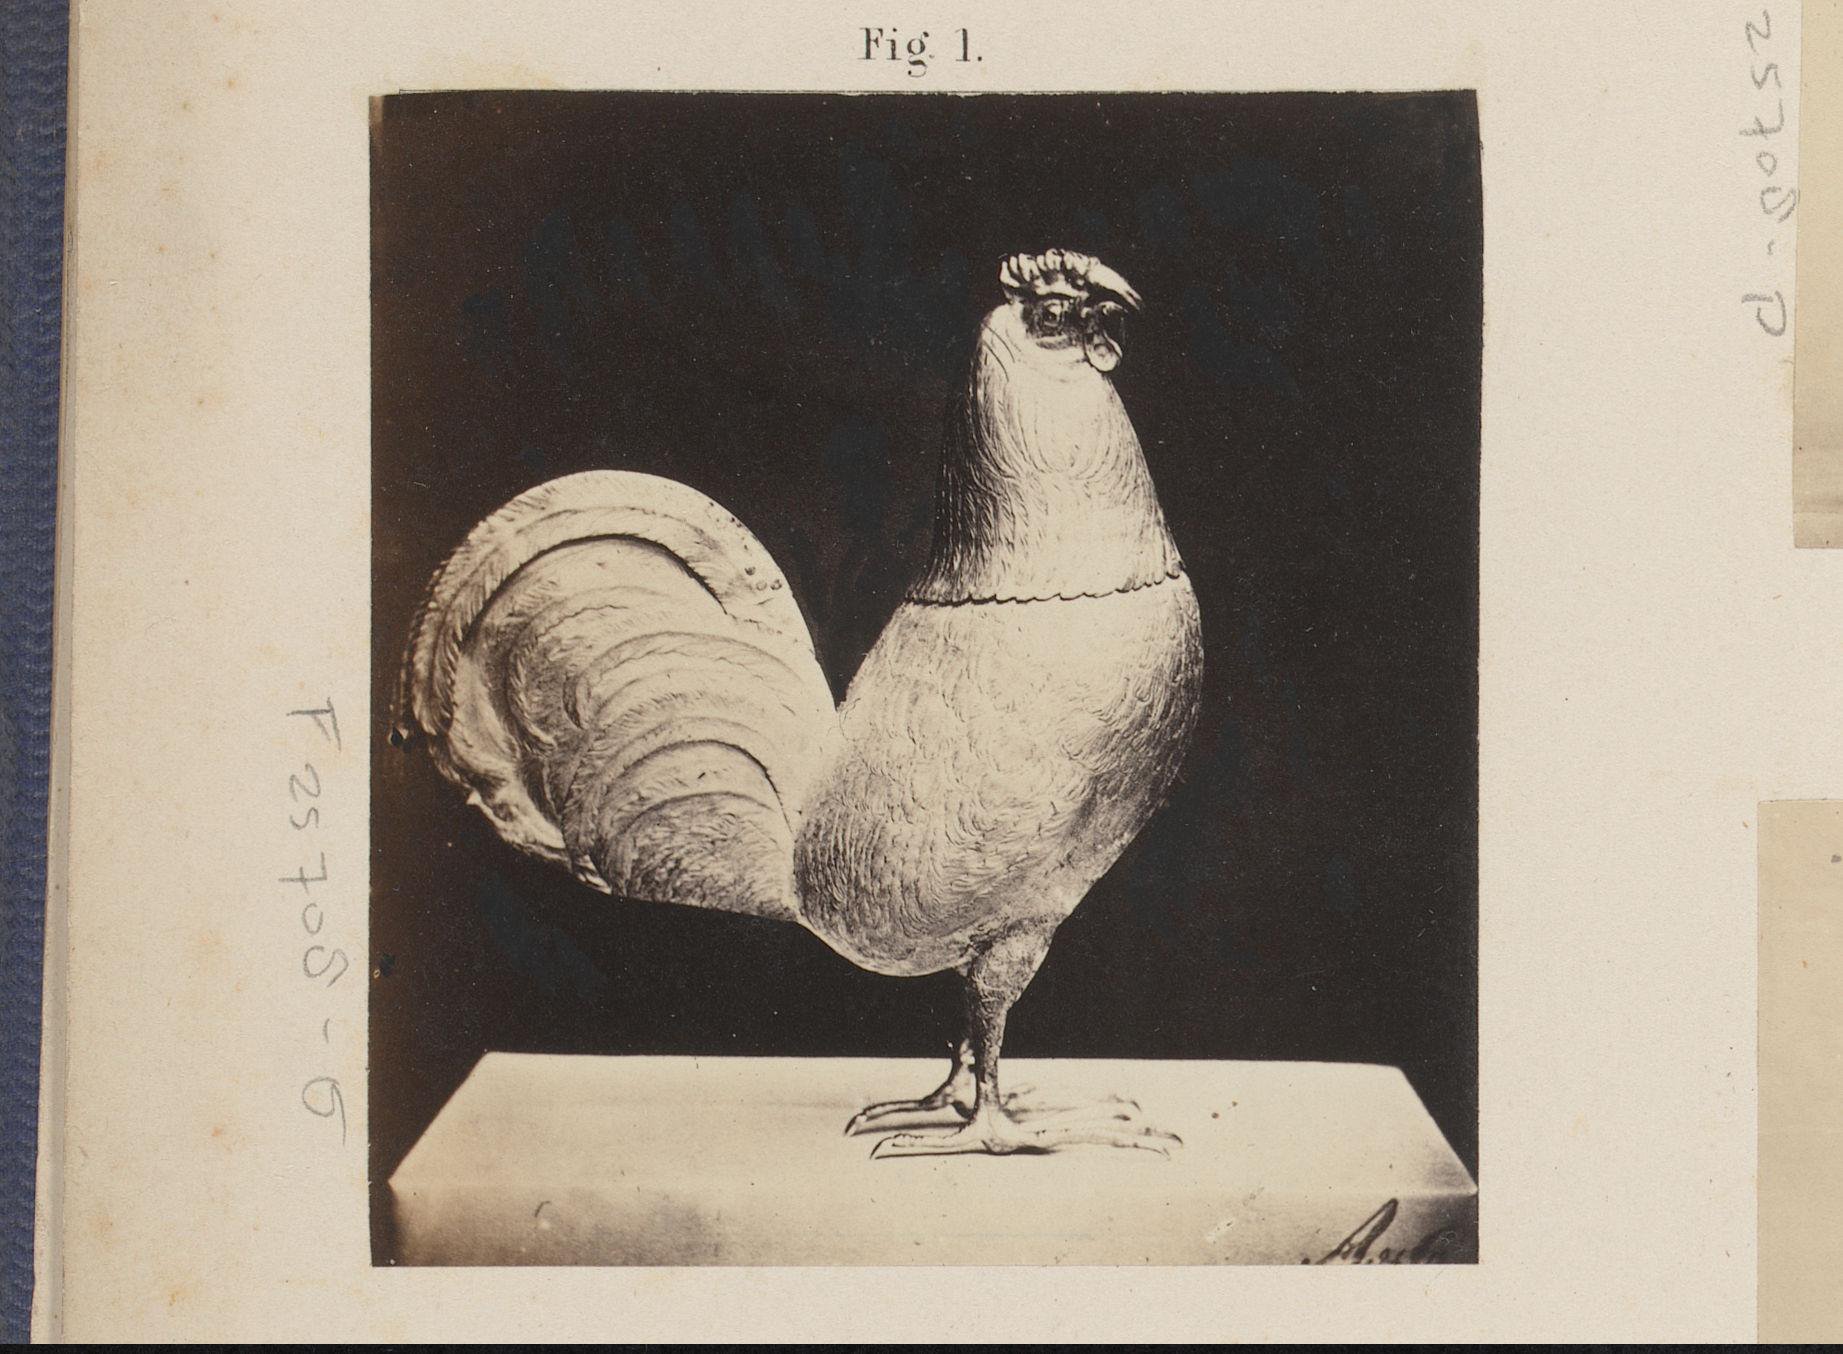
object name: photograph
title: Mat-zilveren haan-beker, 17de eeuw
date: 1855-1863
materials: cardboard, paper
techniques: albumen print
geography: delft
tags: minerals and metals: silver, mug, beaker, goblet, fowl (cock, hen, chicken, etc.), delft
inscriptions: inscription: ‘Fig. 1.’, inscription: ‘PLAAT VII.’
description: Deze foto maakt deel uit van een omslag met 35 foto's op 16 bladen.